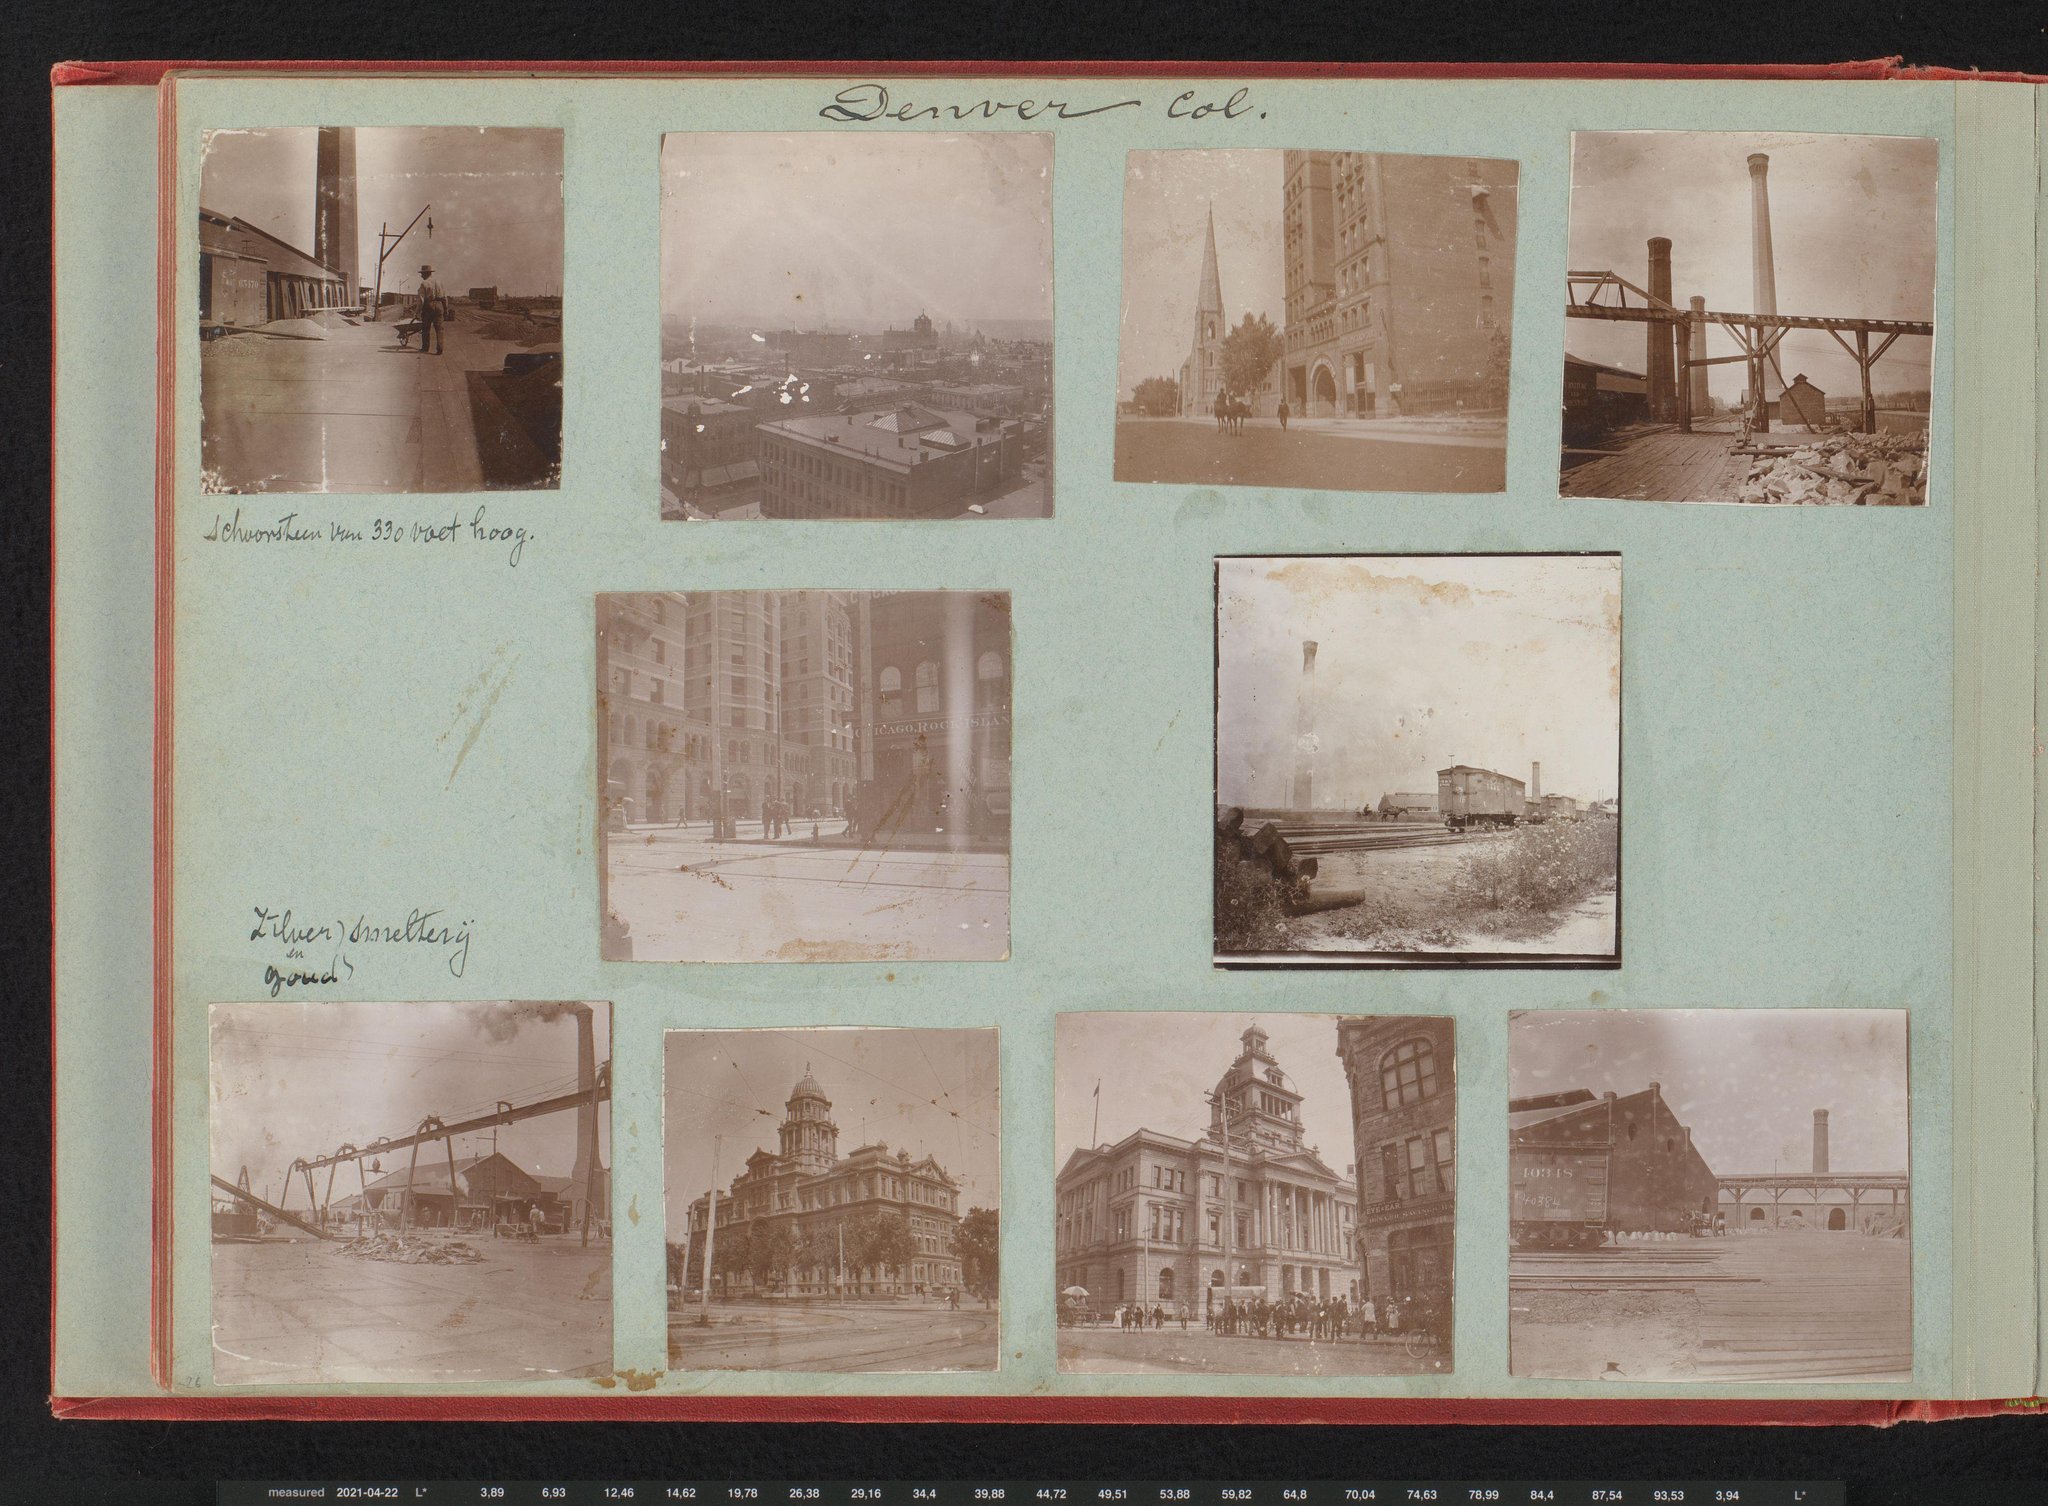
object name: photograph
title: Denver, Col.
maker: Anonymous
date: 1898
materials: paper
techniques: collodion silver print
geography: denver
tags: street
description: Deze foto's zijn onderdeel van een album.